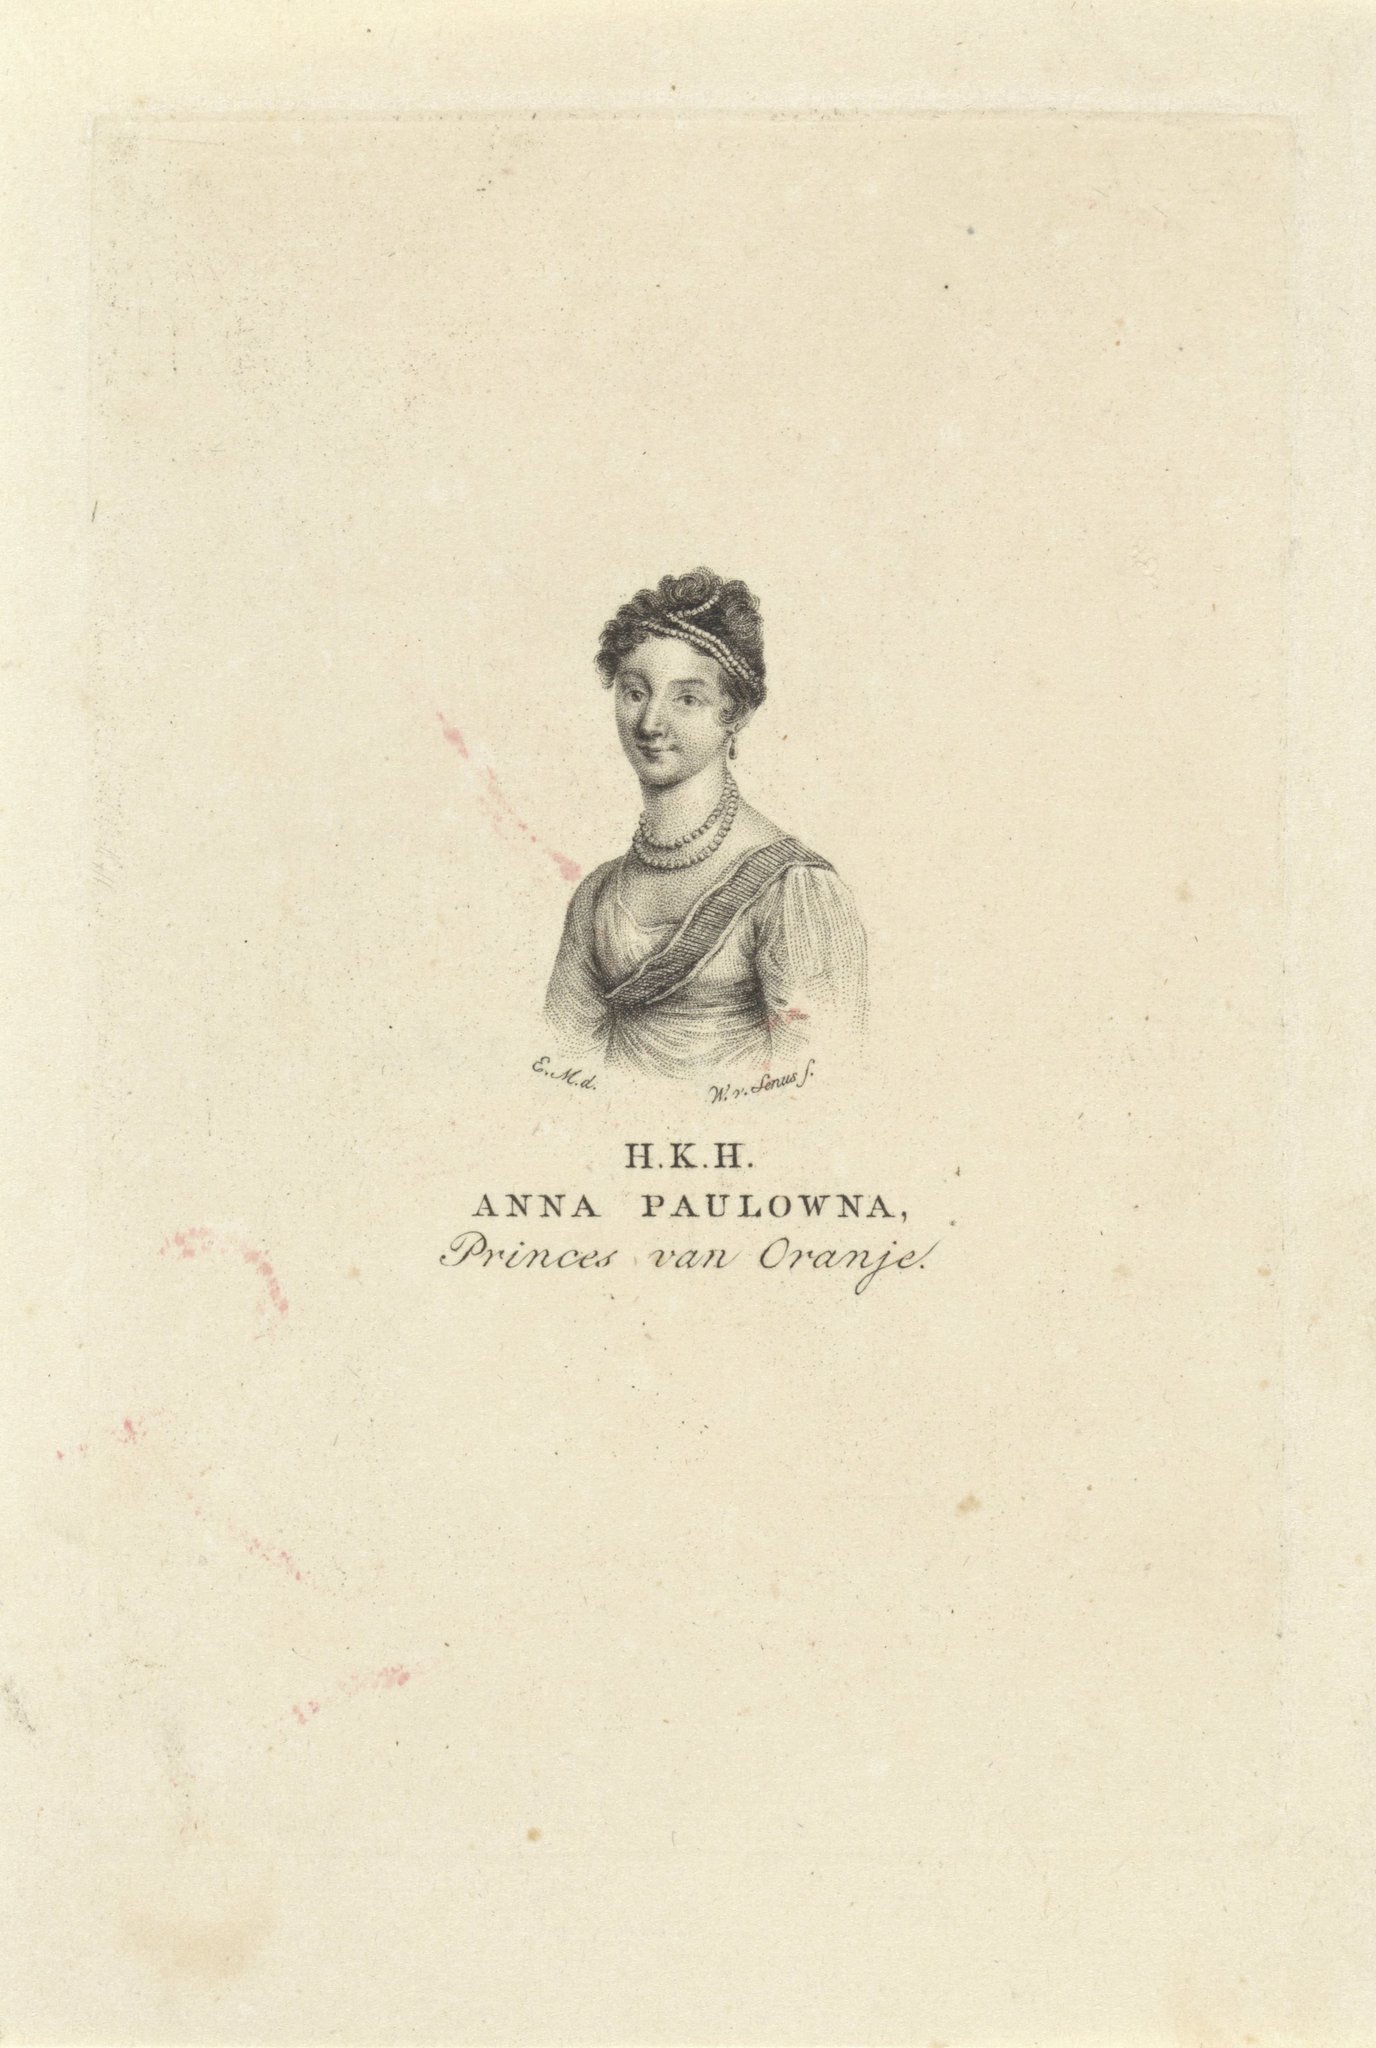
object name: print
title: Portret van Anna Paulowna Romanowa (koningin der Nederlanden)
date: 1816-1840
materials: paper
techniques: etching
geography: netherlands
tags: the hague, anna paulowna romanowa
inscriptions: collector's mark: Lugt 2228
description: Portret van Anna Paulowna Romanowa (koningin der Nederlanden), met parelsnoer.